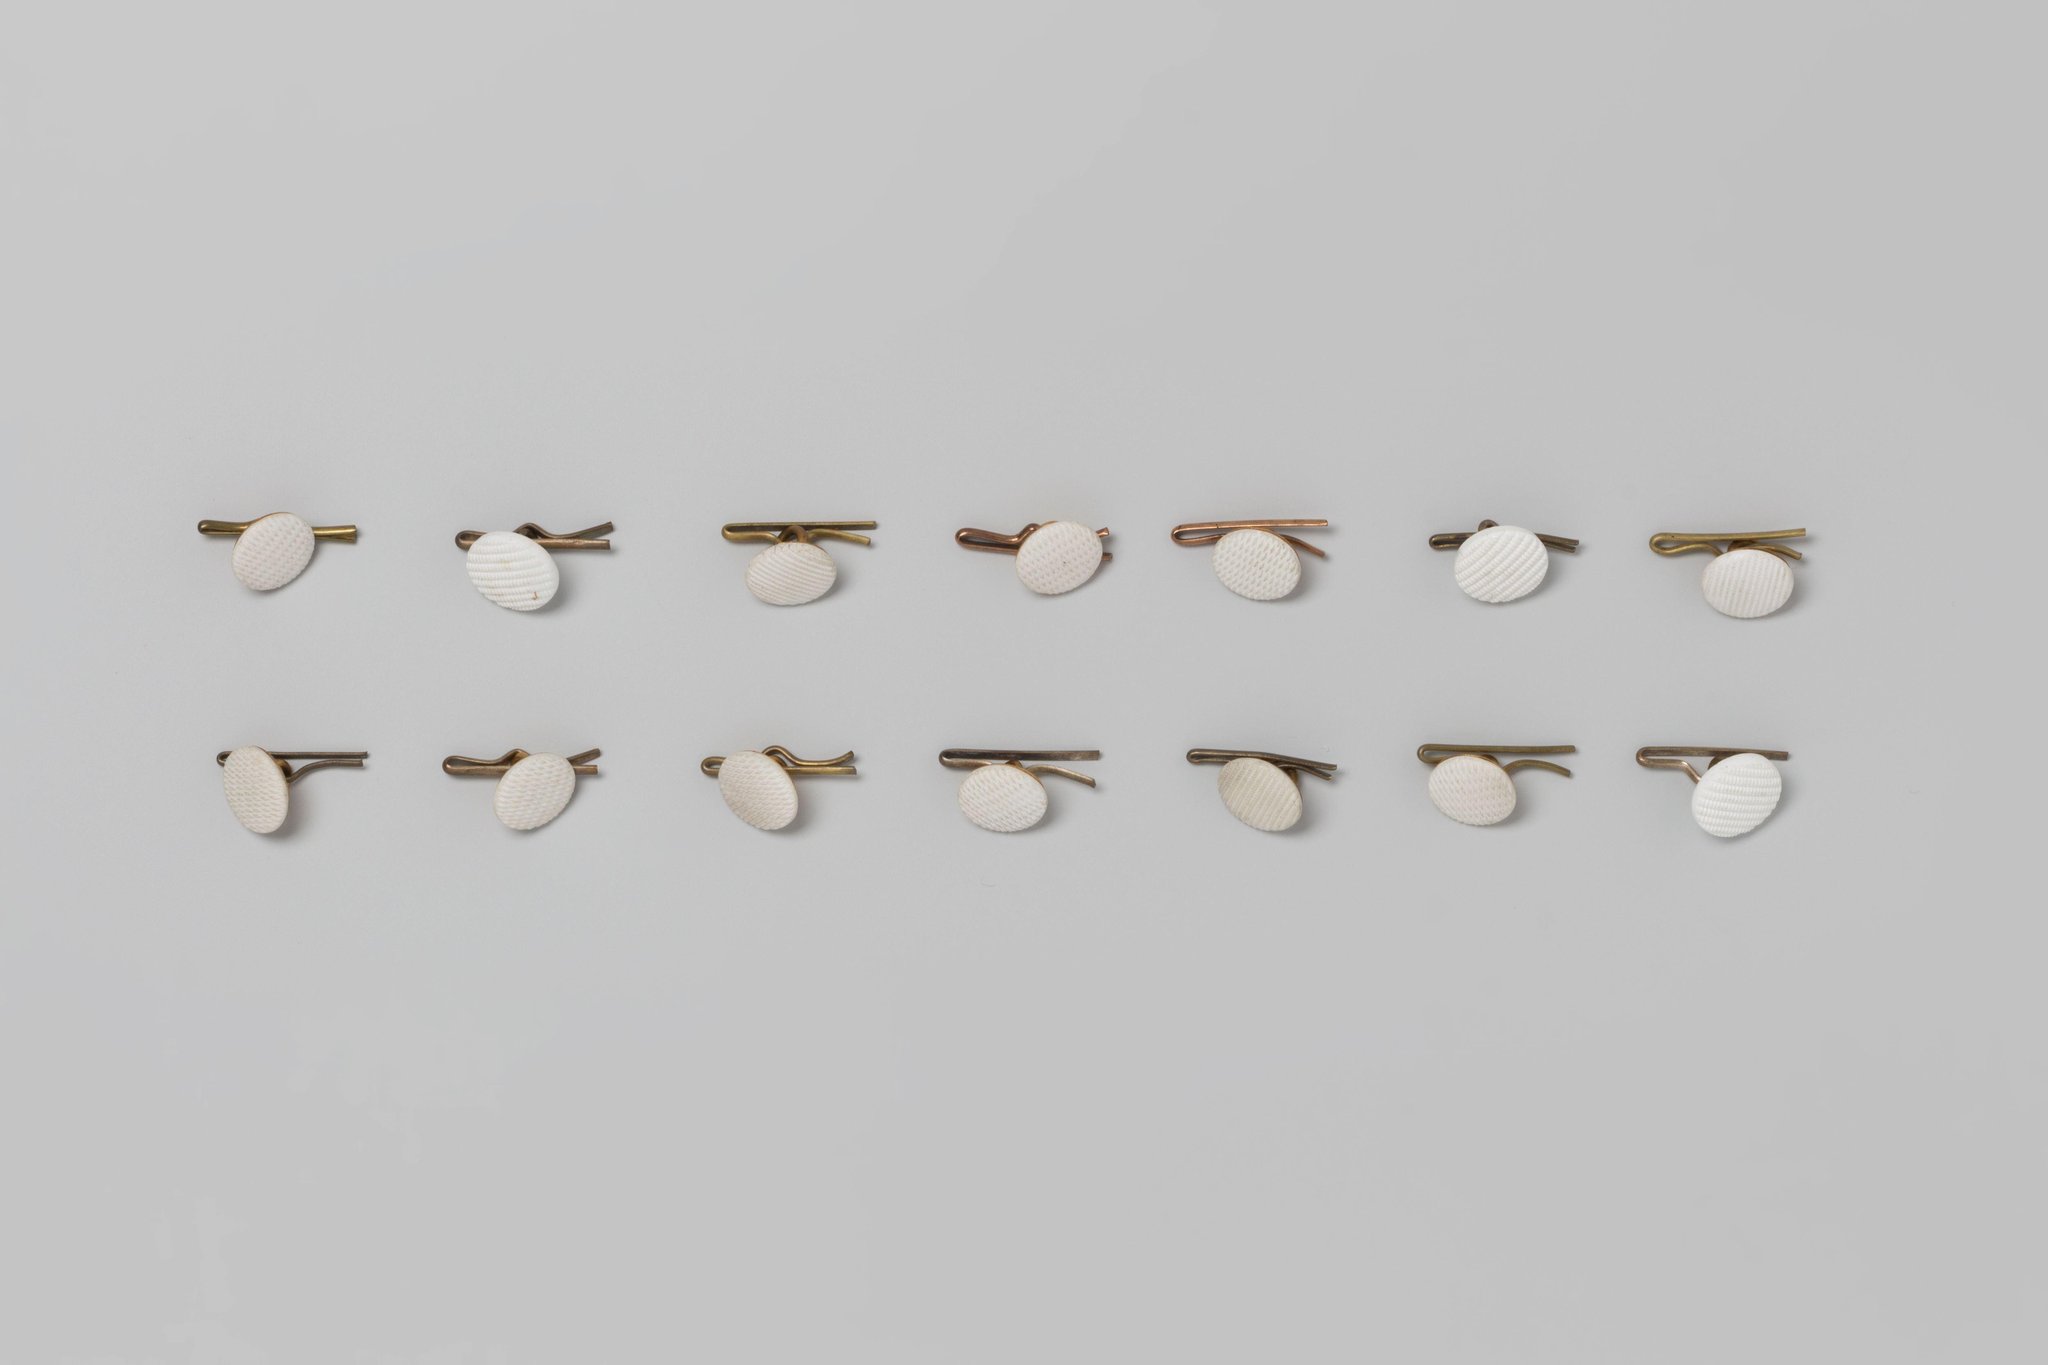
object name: vestknoop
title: Vestknoop van kunststof met reliëf-ribbel, vast oogje en losse tegenklem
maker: Anonymous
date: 1900-1940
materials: copper, plastic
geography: netherlands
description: Vestknoop van kunststof met reliëf-ribbel, vast oogje en losse tegenklem.